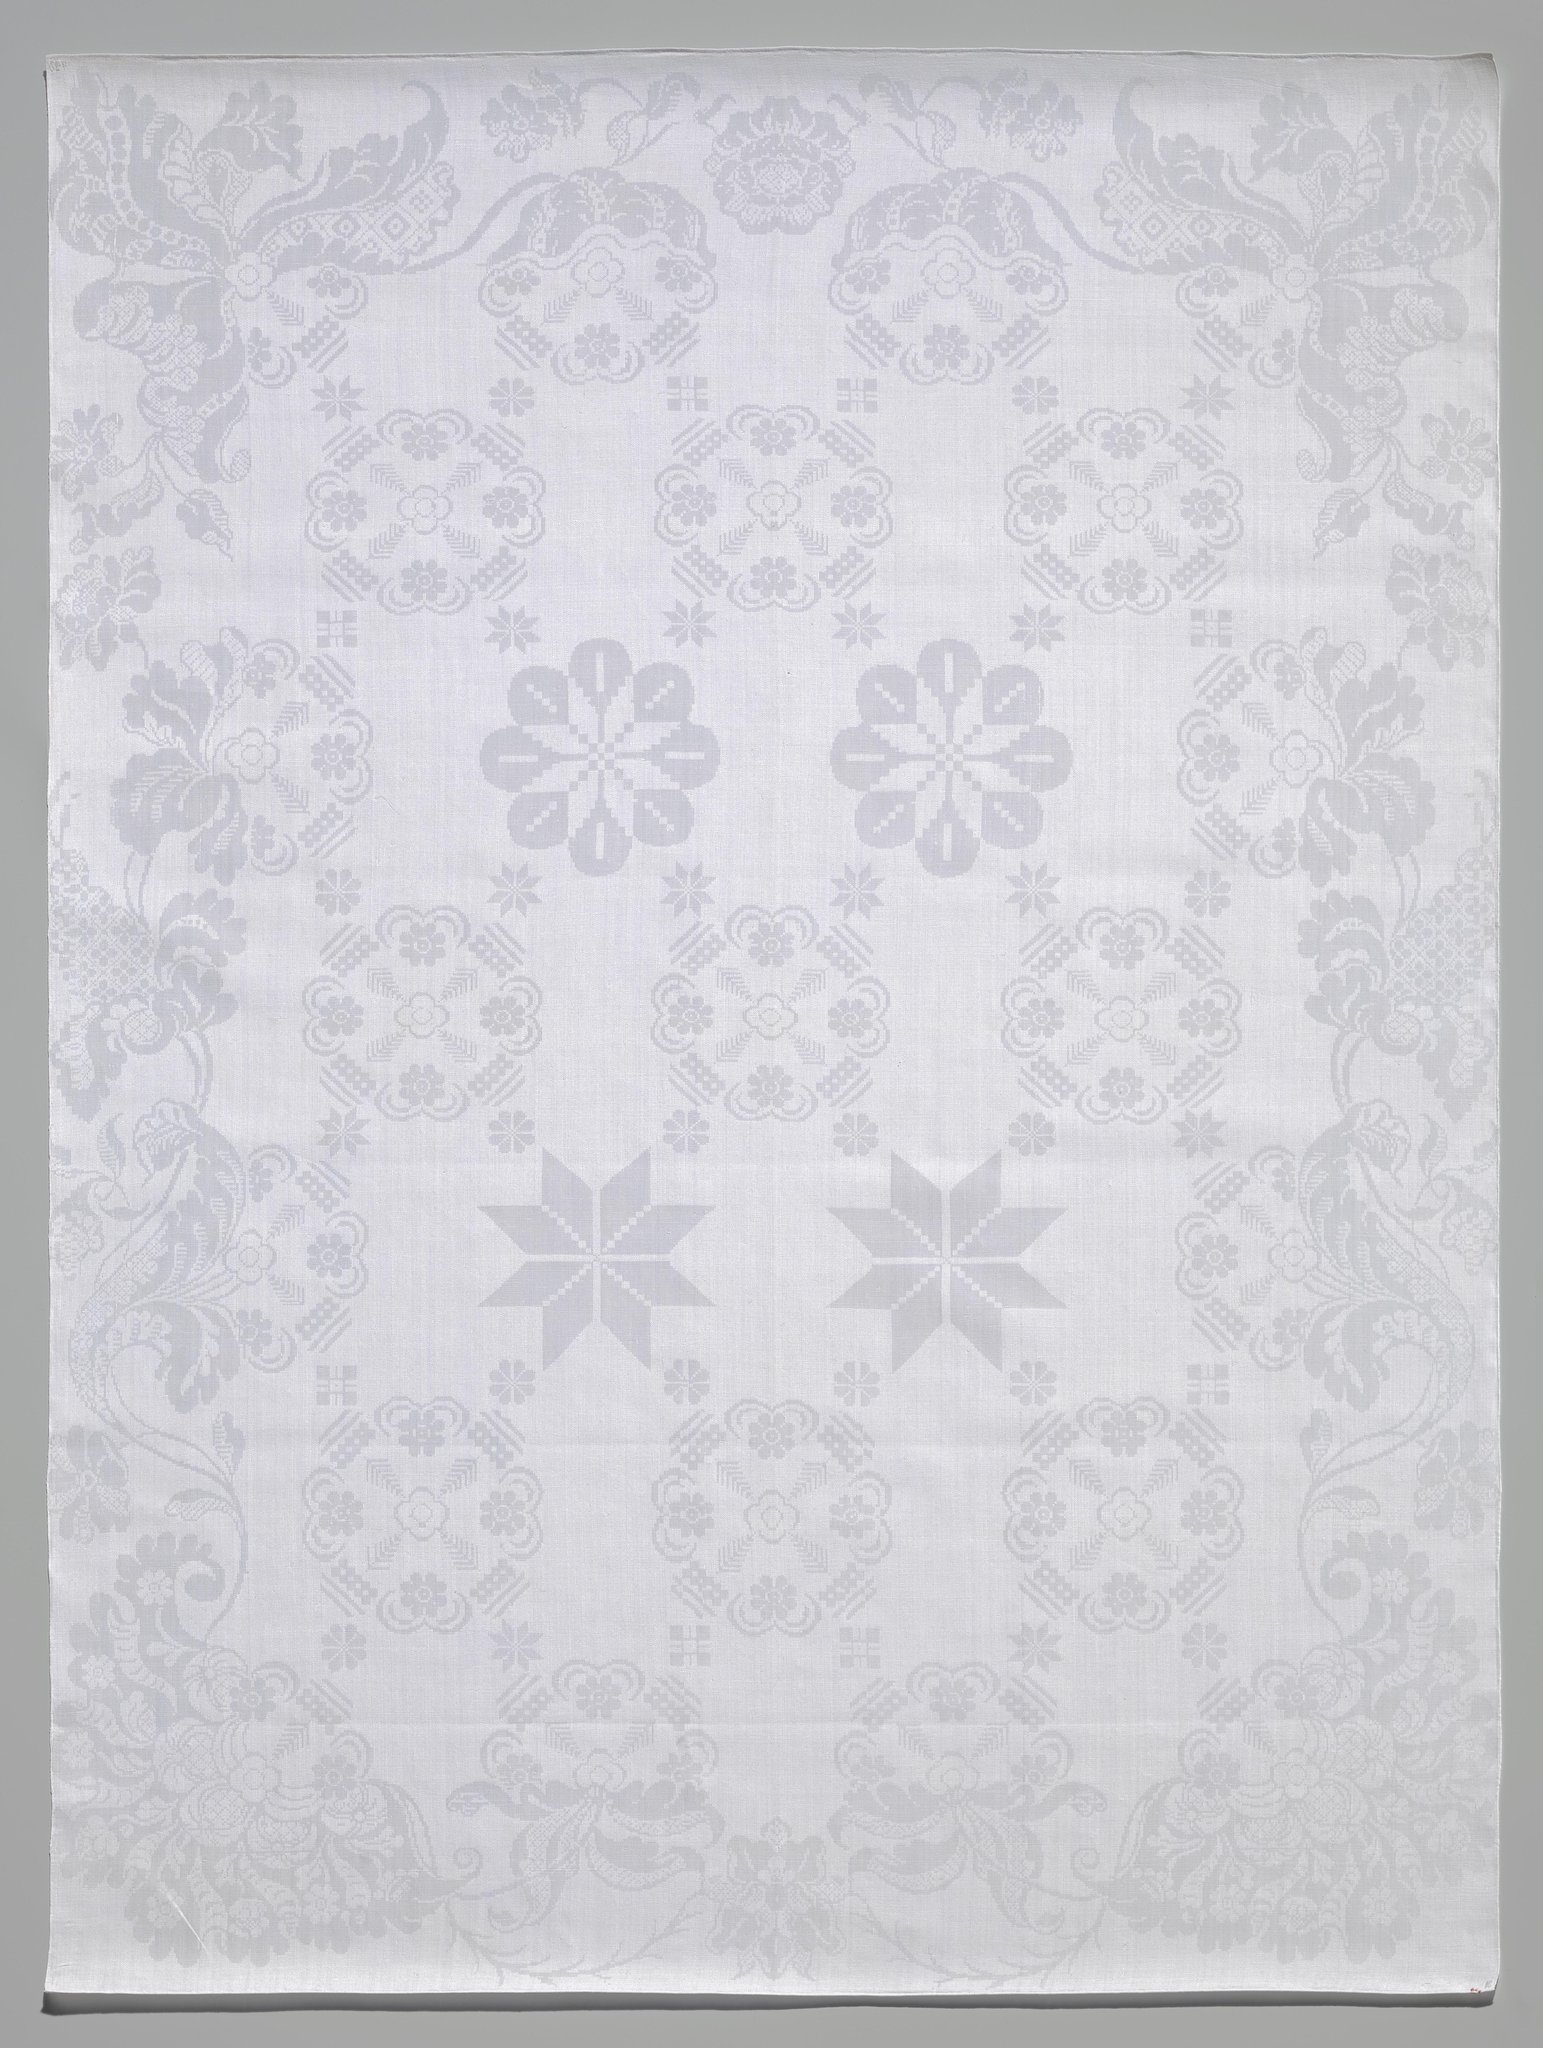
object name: napkin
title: Servet met patroon van sterren en rozetten en rococorand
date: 1740-1750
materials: linen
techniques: damask, weave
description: Servet van linnendamast met op het veld een geometrisch patroon van sterren en rozetten (pellenachtig). Daaromheen loopt een rococorand met bloemranken met grote bladeren en in de hoeken een bloementoef. Merk: oorspronkelijk blauwe kruissteek GDW en 38. Bij het servet hoort een servet met invnr. BK-1979-53-B.